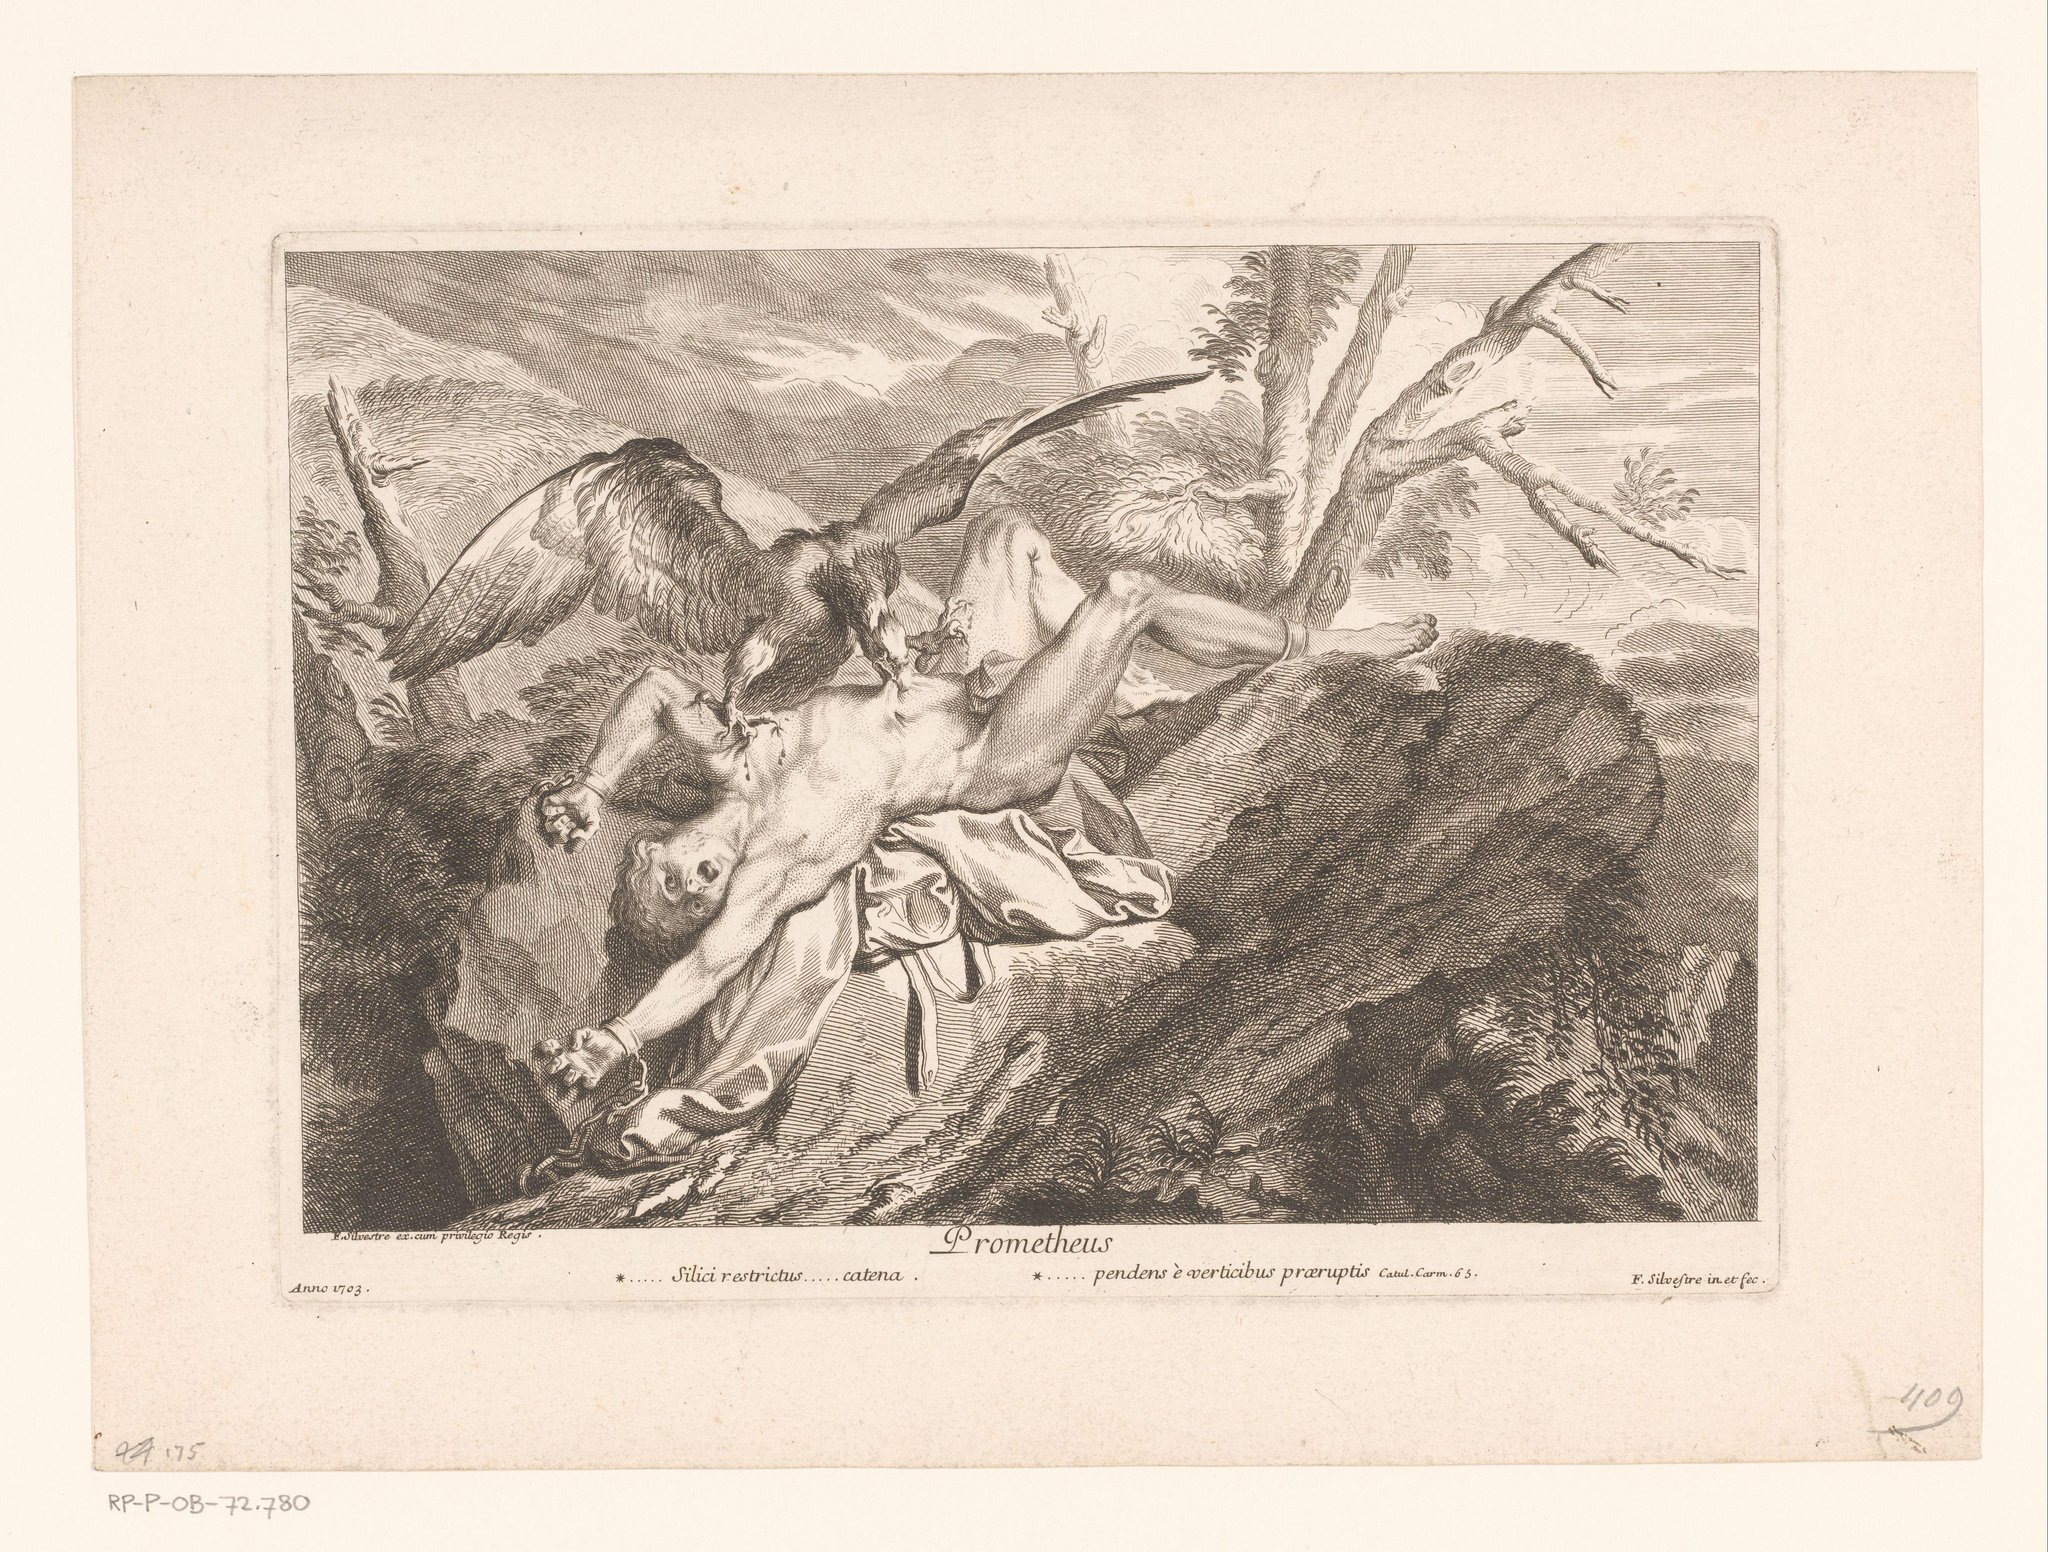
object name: print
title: Bestraffing van Prometheus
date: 1703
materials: paper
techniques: engraving, etching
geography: france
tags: an eagle tears at prometheus' liver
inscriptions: collector's mark: Lugt 240